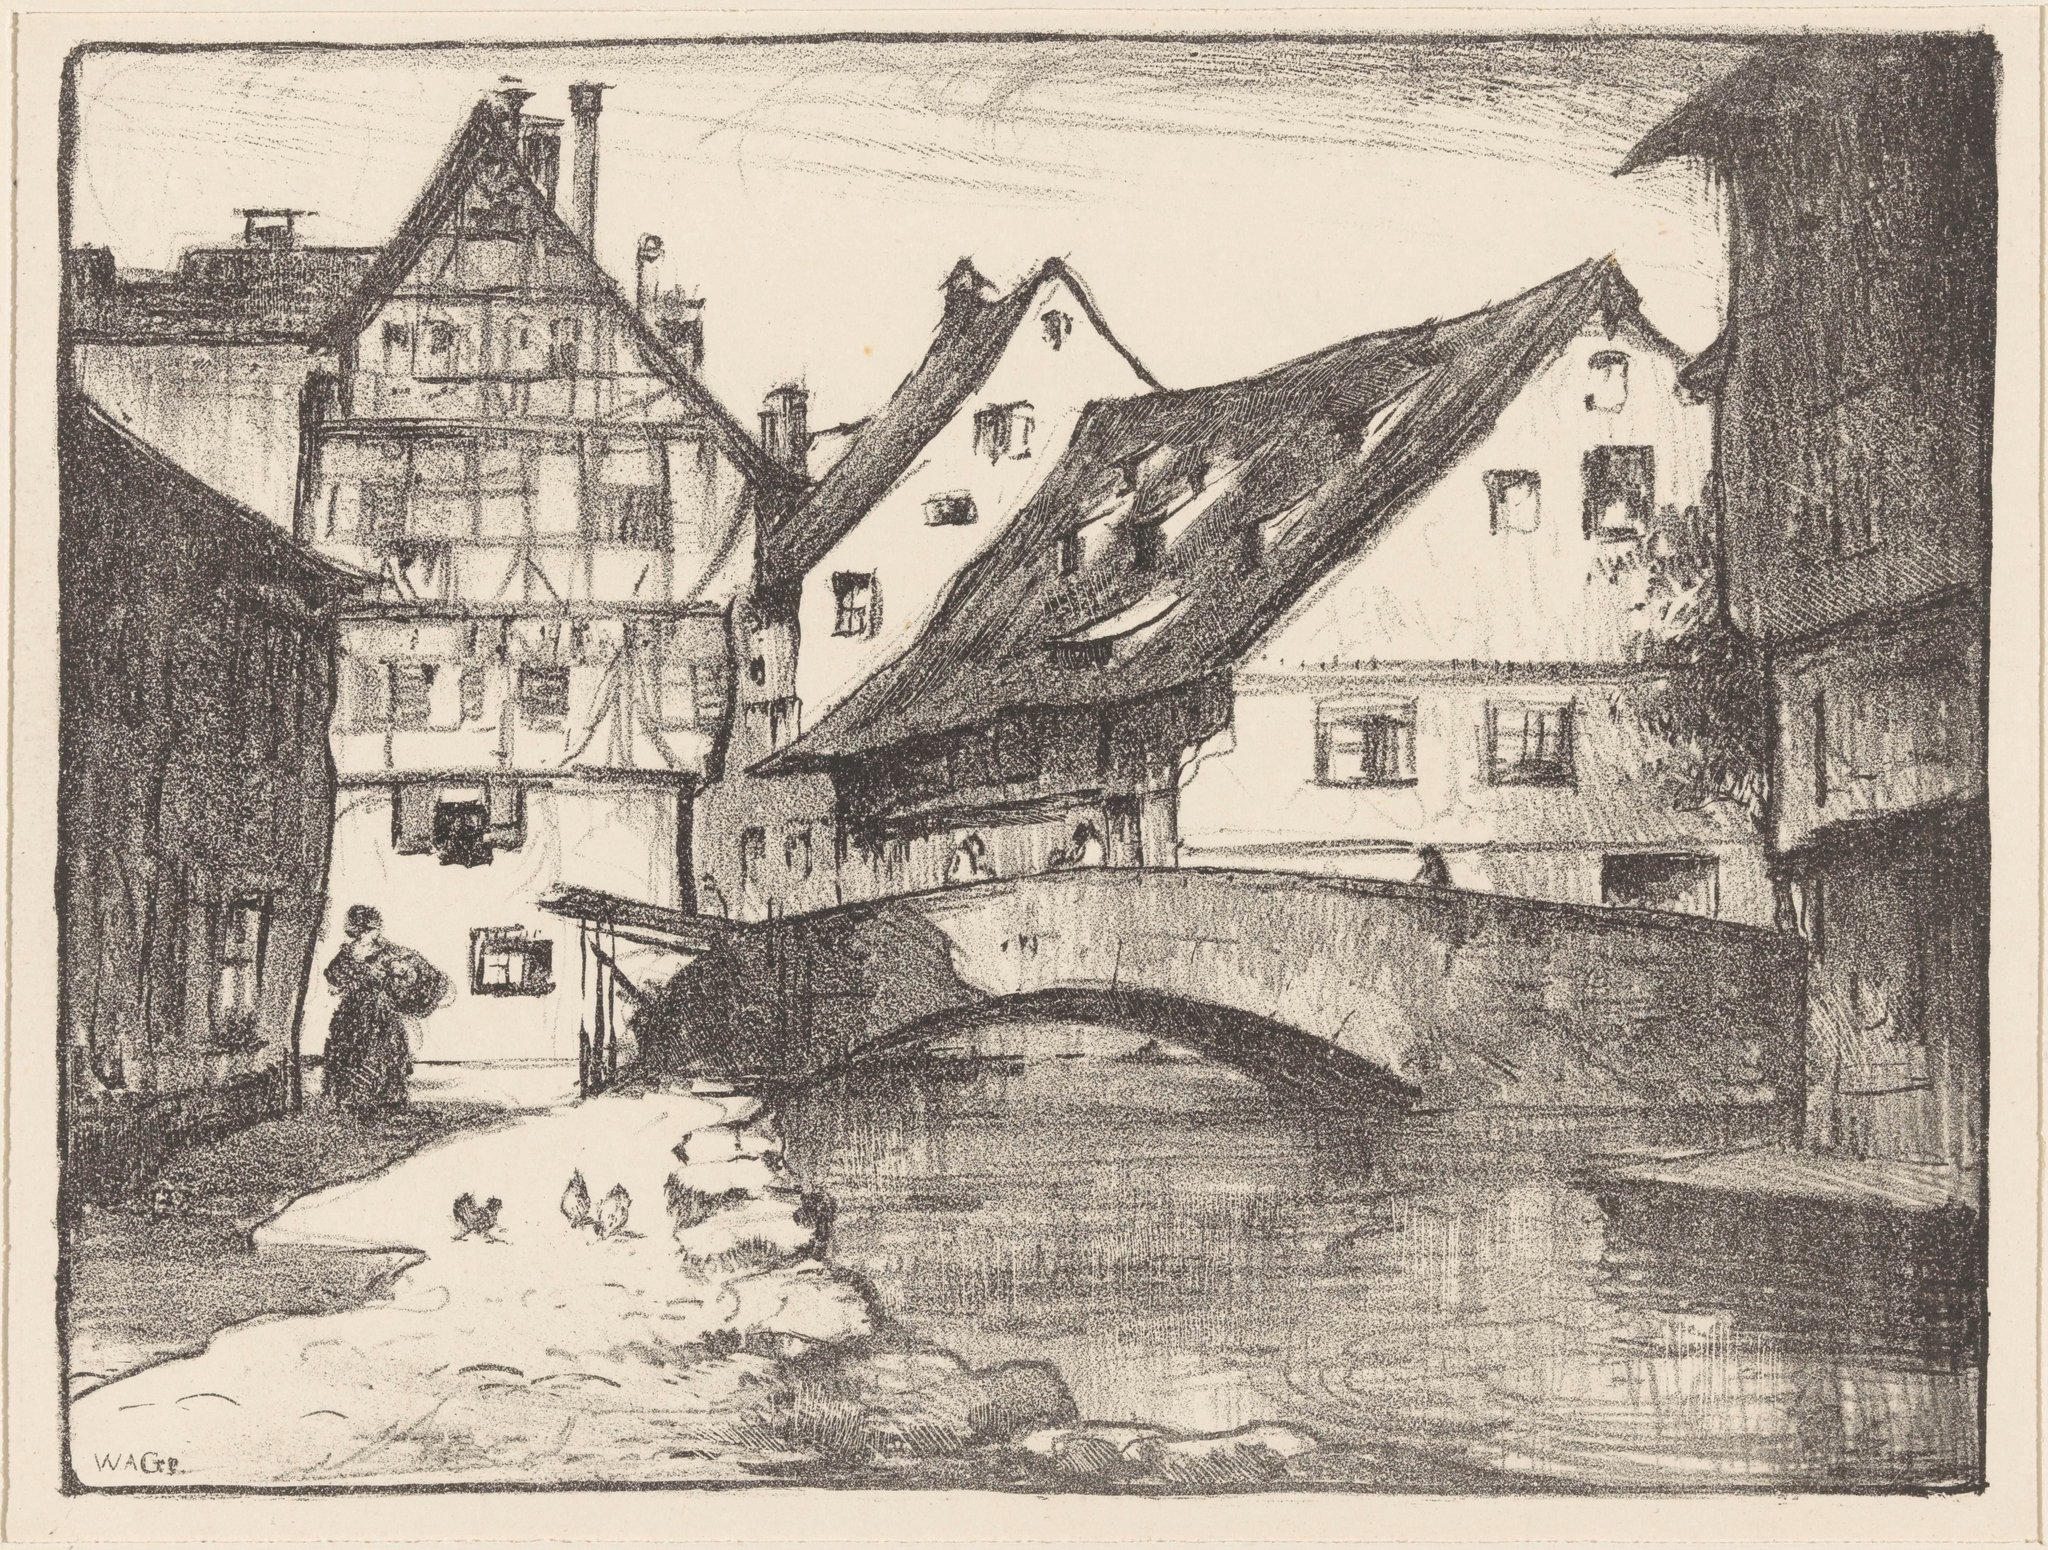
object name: print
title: Ulm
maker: willem adrianus grondhout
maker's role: draughtsman, painter, print maker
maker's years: 1878-1934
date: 1888-1934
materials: paper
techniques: lithograph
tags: bridge in city across river, canal, etc.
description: Wandelende figuren op een brug over een rivier in het Duitse Ulm. Op beide oevers bebouwing.